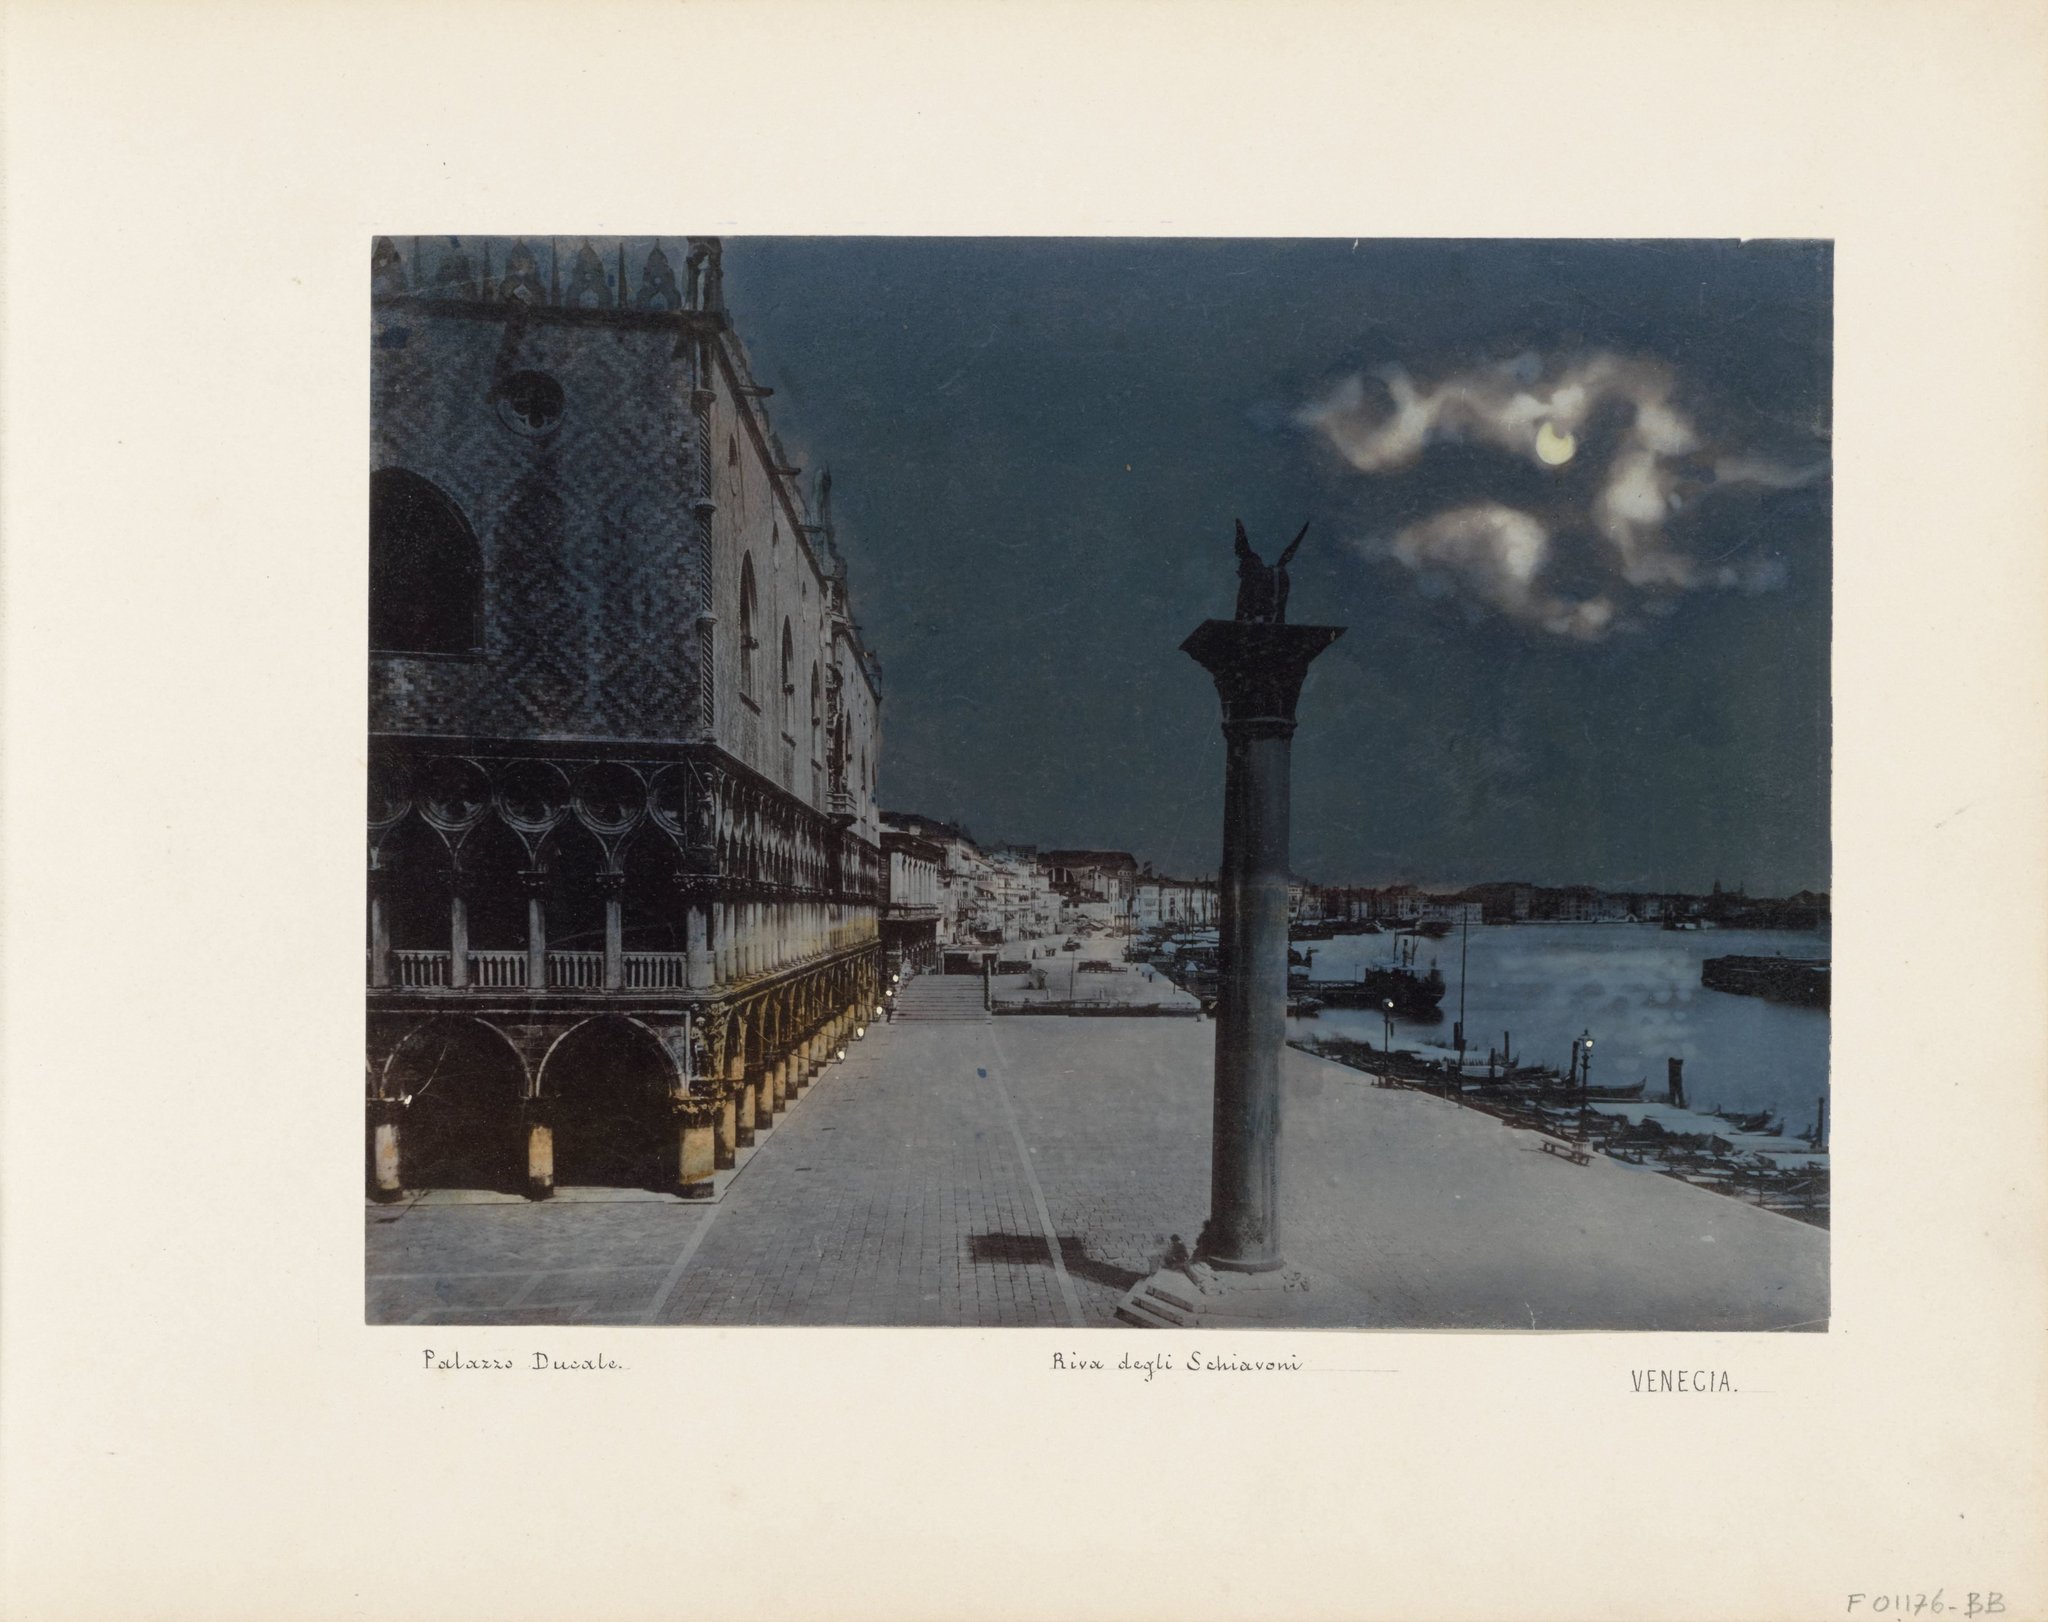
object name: photograph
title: Riva degli Schiavoni, pilaar met leeuwenbeeld en het Dogepaleis in Venetië bij nacht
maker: Anonymous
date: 1850-1876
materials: photographic support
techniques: albumen print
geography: venice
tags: palace, piece of sculpture, reproduction of a piece of sculpture, travelling; tourism, night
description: Onderdeel van Reisalbum met foto's en tekeningen van Manuel Mayo 1876.